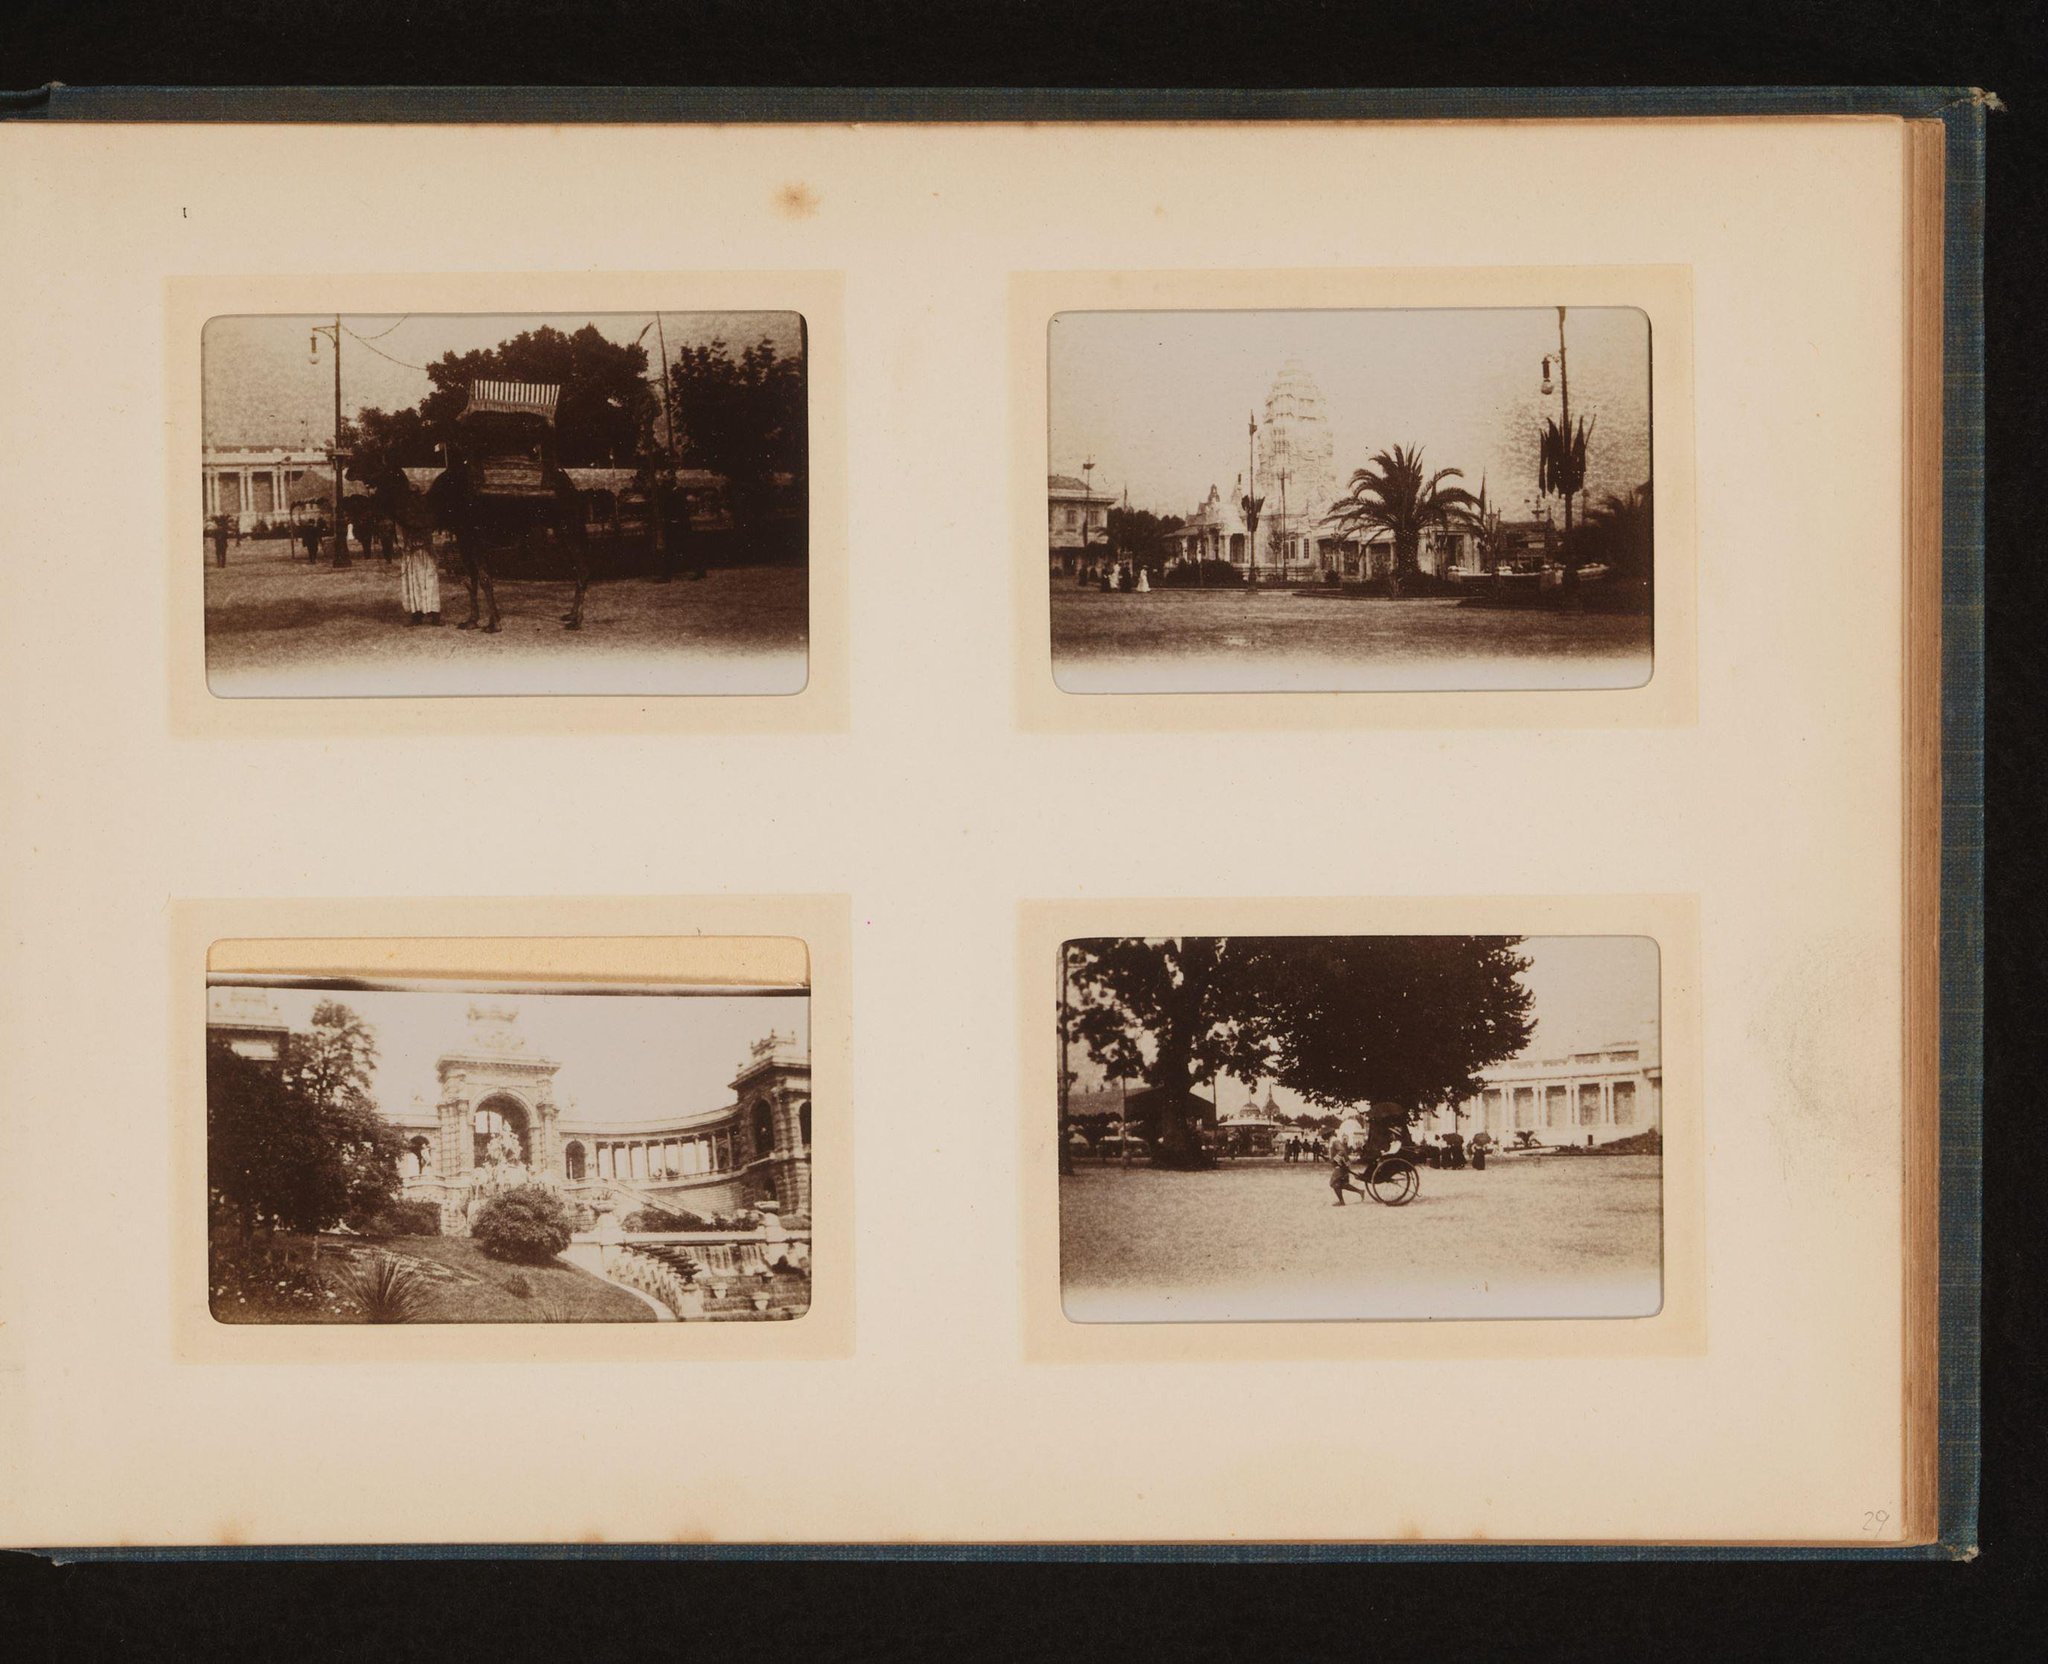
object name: photograph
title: Twee stadsgezichten, Gezicht op een gebouw en Dromedaris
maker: Anonymous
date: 1900-1915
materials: paper, photographic support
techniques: gelatin silver print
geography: france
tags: hoofed animals: dromedary, city-view in general; 'veduta', travelling; tourism, civic architecture; edifices; dwellings, france